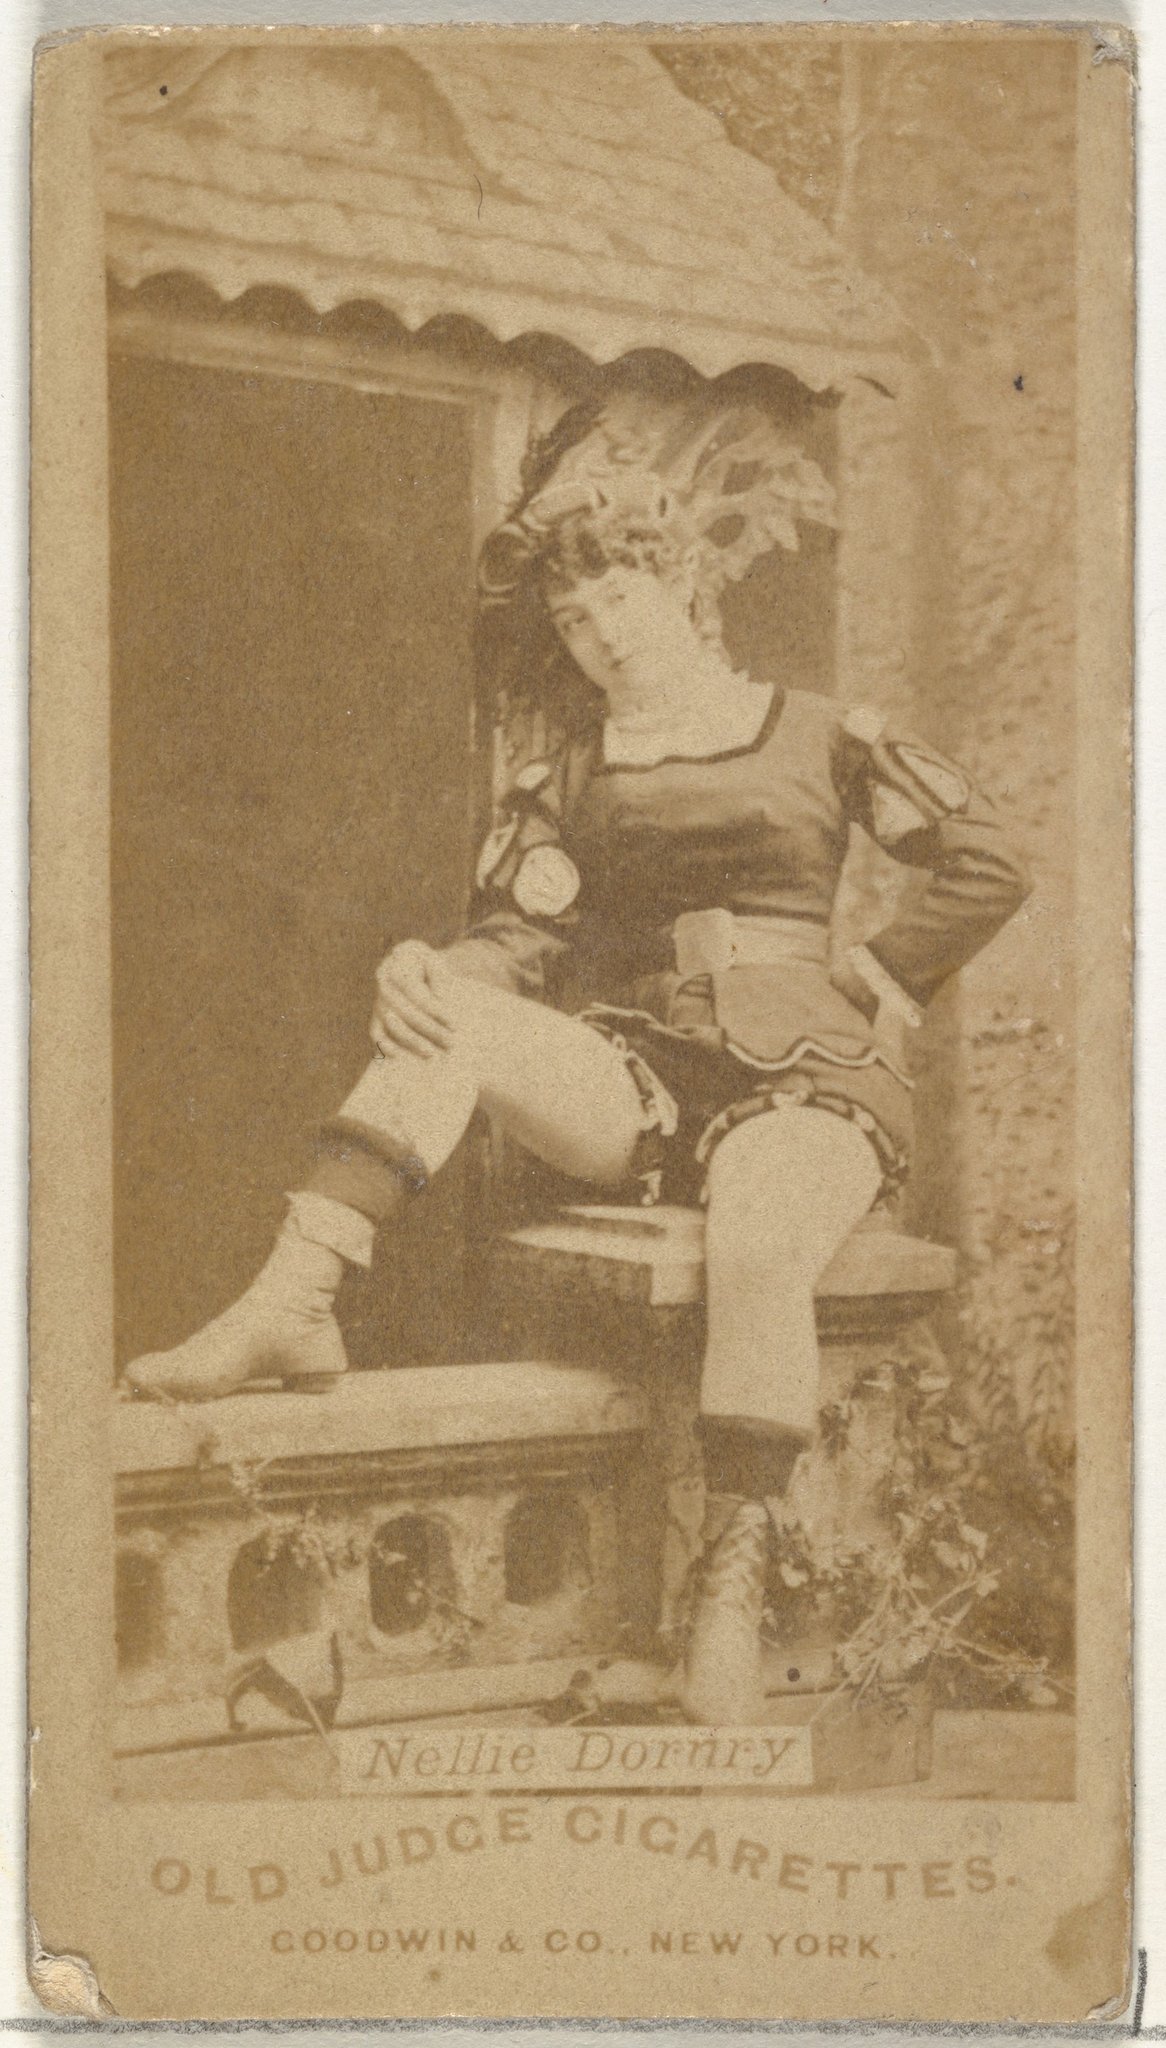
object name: photograph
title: Nellie Dornry, from the Actors and Actresses series (N171) for Old Judge Cigarettes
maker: goodwin & company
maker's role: publisher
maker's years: 1850-1950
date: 1886-1890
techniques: albumen silver print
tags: portraits,women,actresses